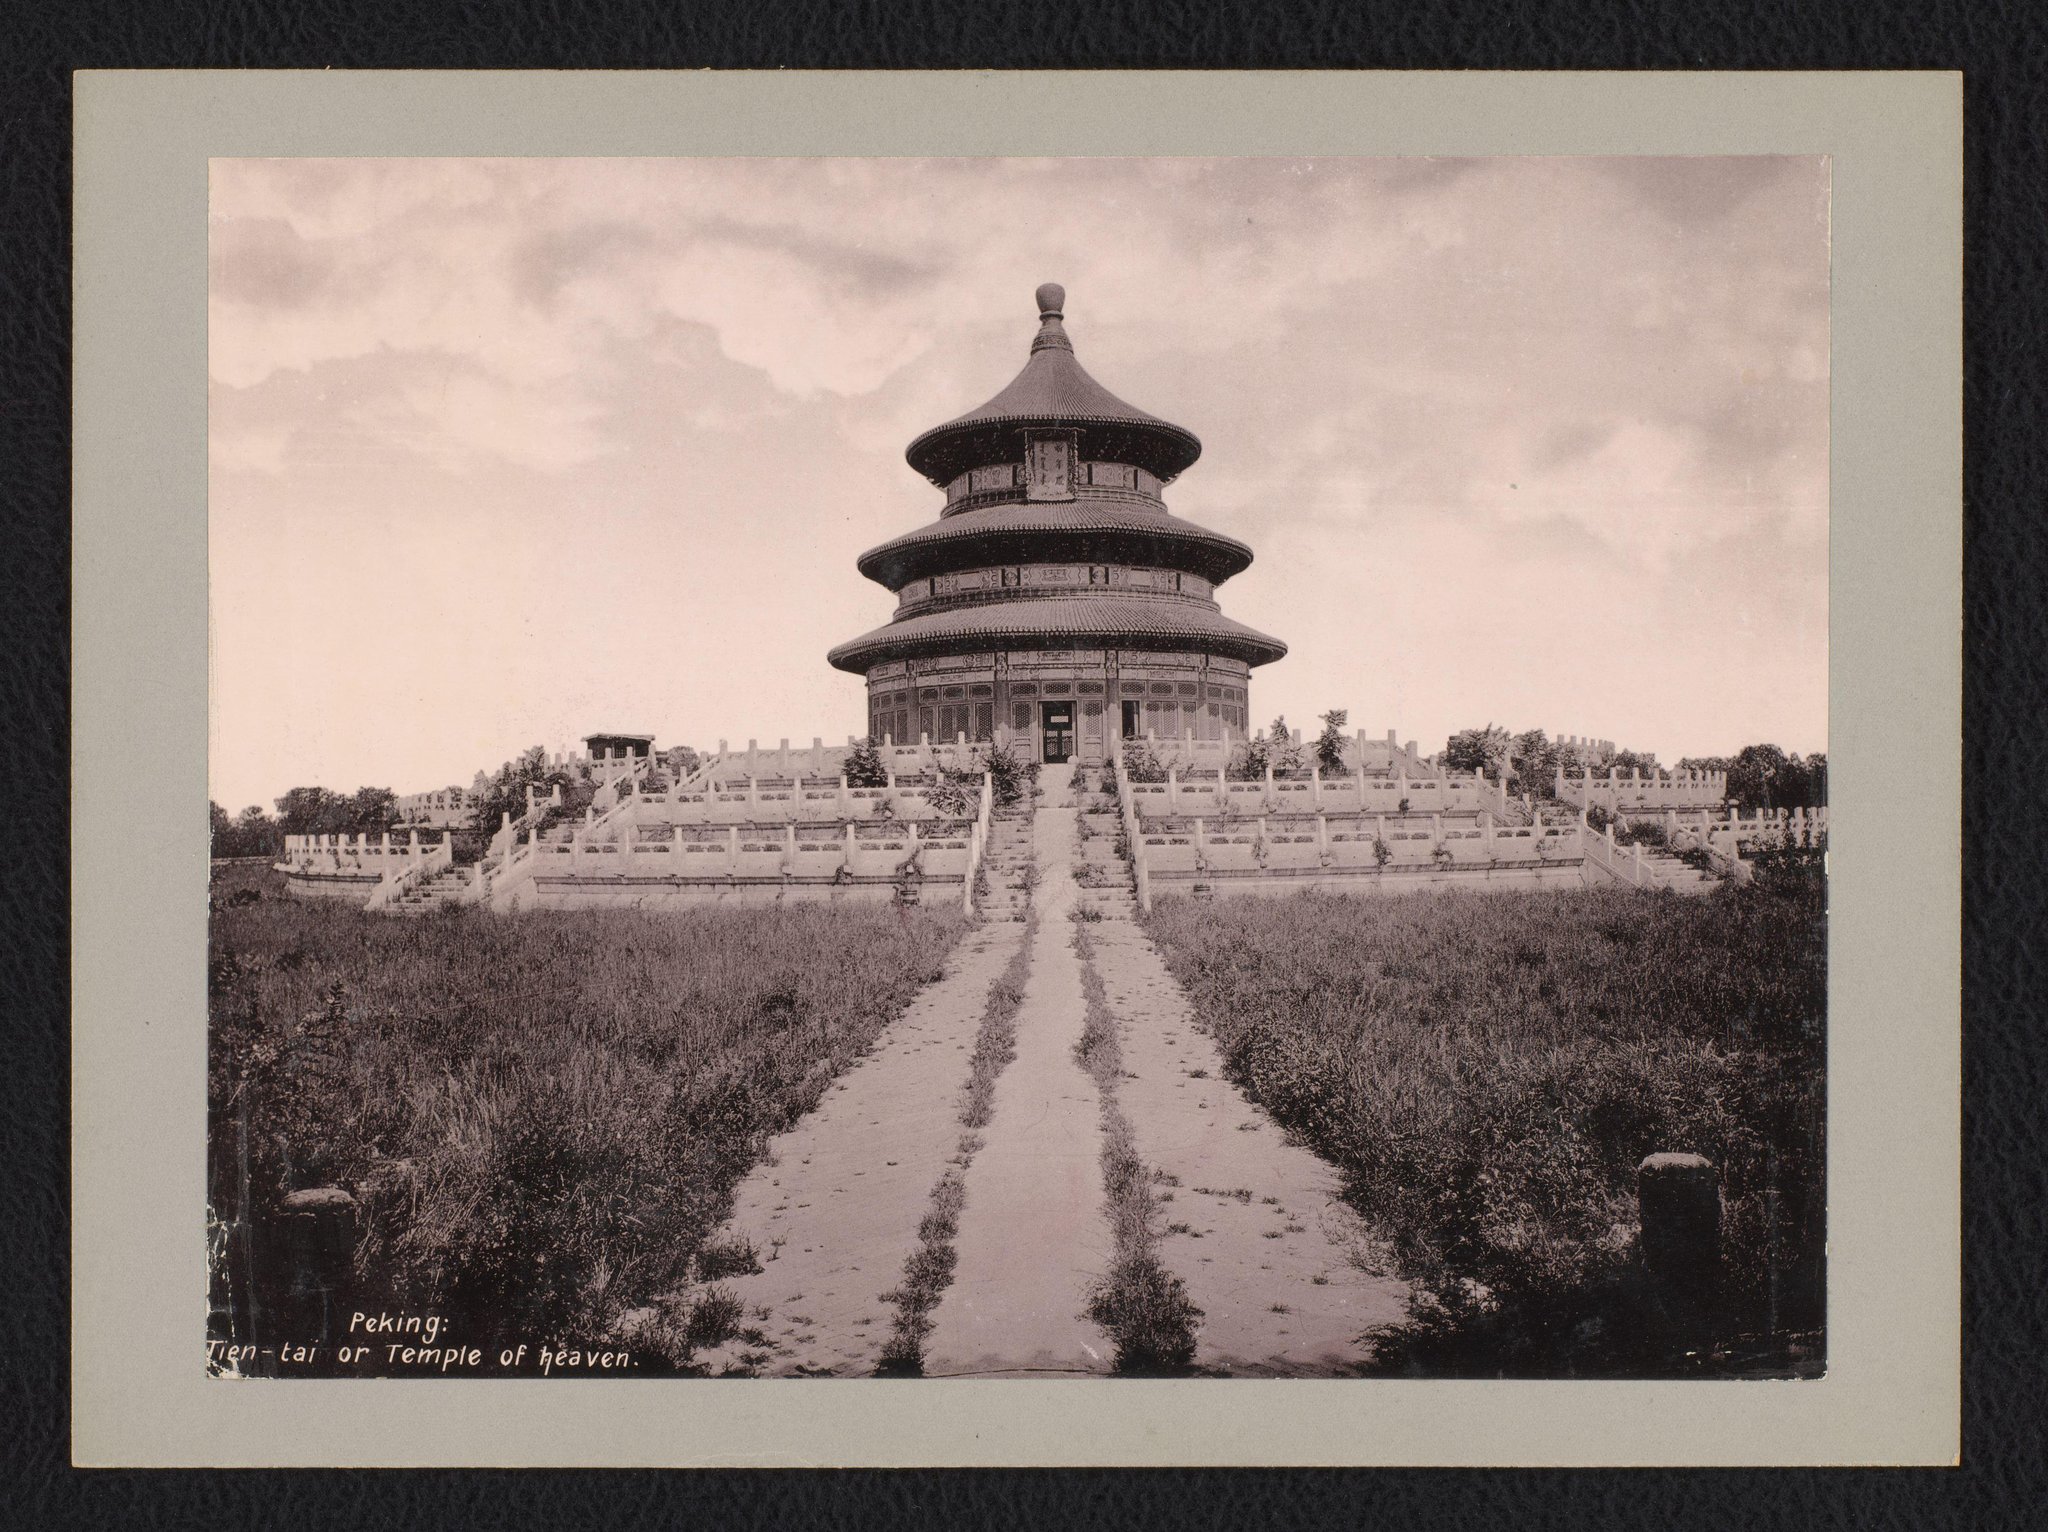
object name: photograph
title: Peking: Tien-tai or Temple of heaven.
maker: Anonymous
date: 1895-1915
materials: cardboard, photographic support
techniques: photograph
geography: beijing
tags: peking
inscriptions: number: ‘2.’